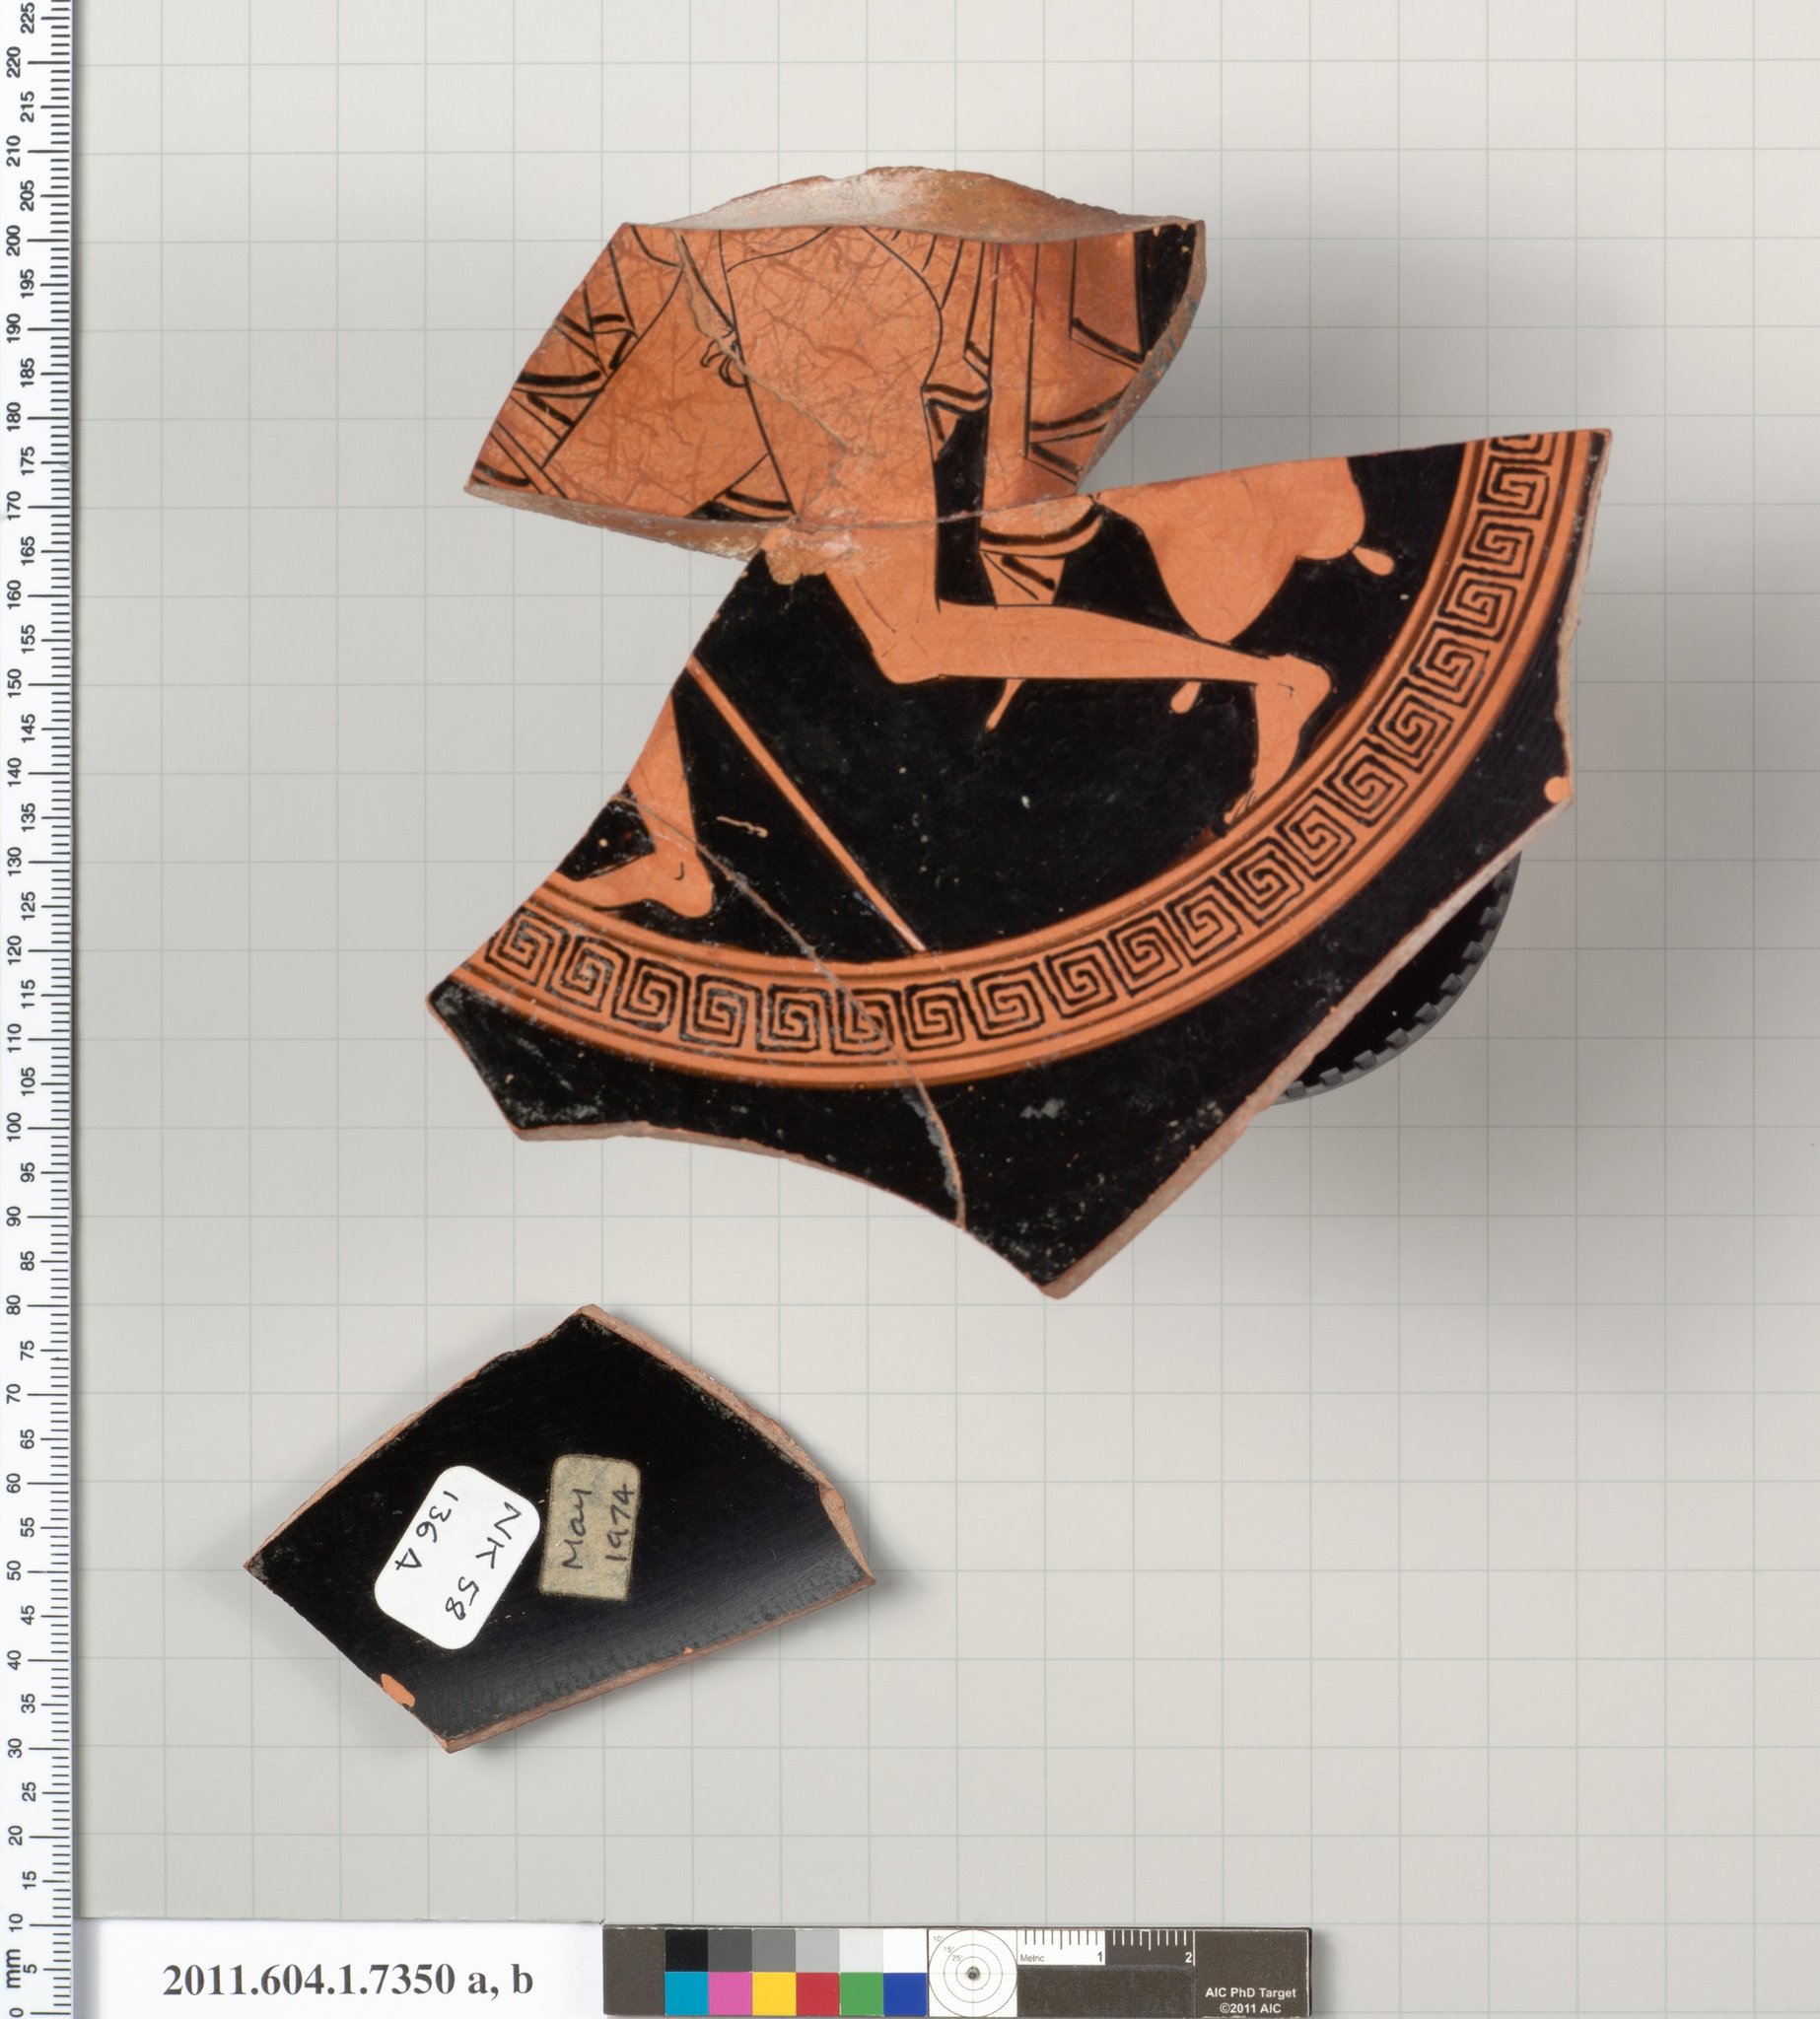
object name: kylix fragment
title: Terracotta fragments of a kylix (drinking cup)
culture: greek, attic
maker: makron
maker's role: artist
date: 500-480 BCE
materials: terracotta